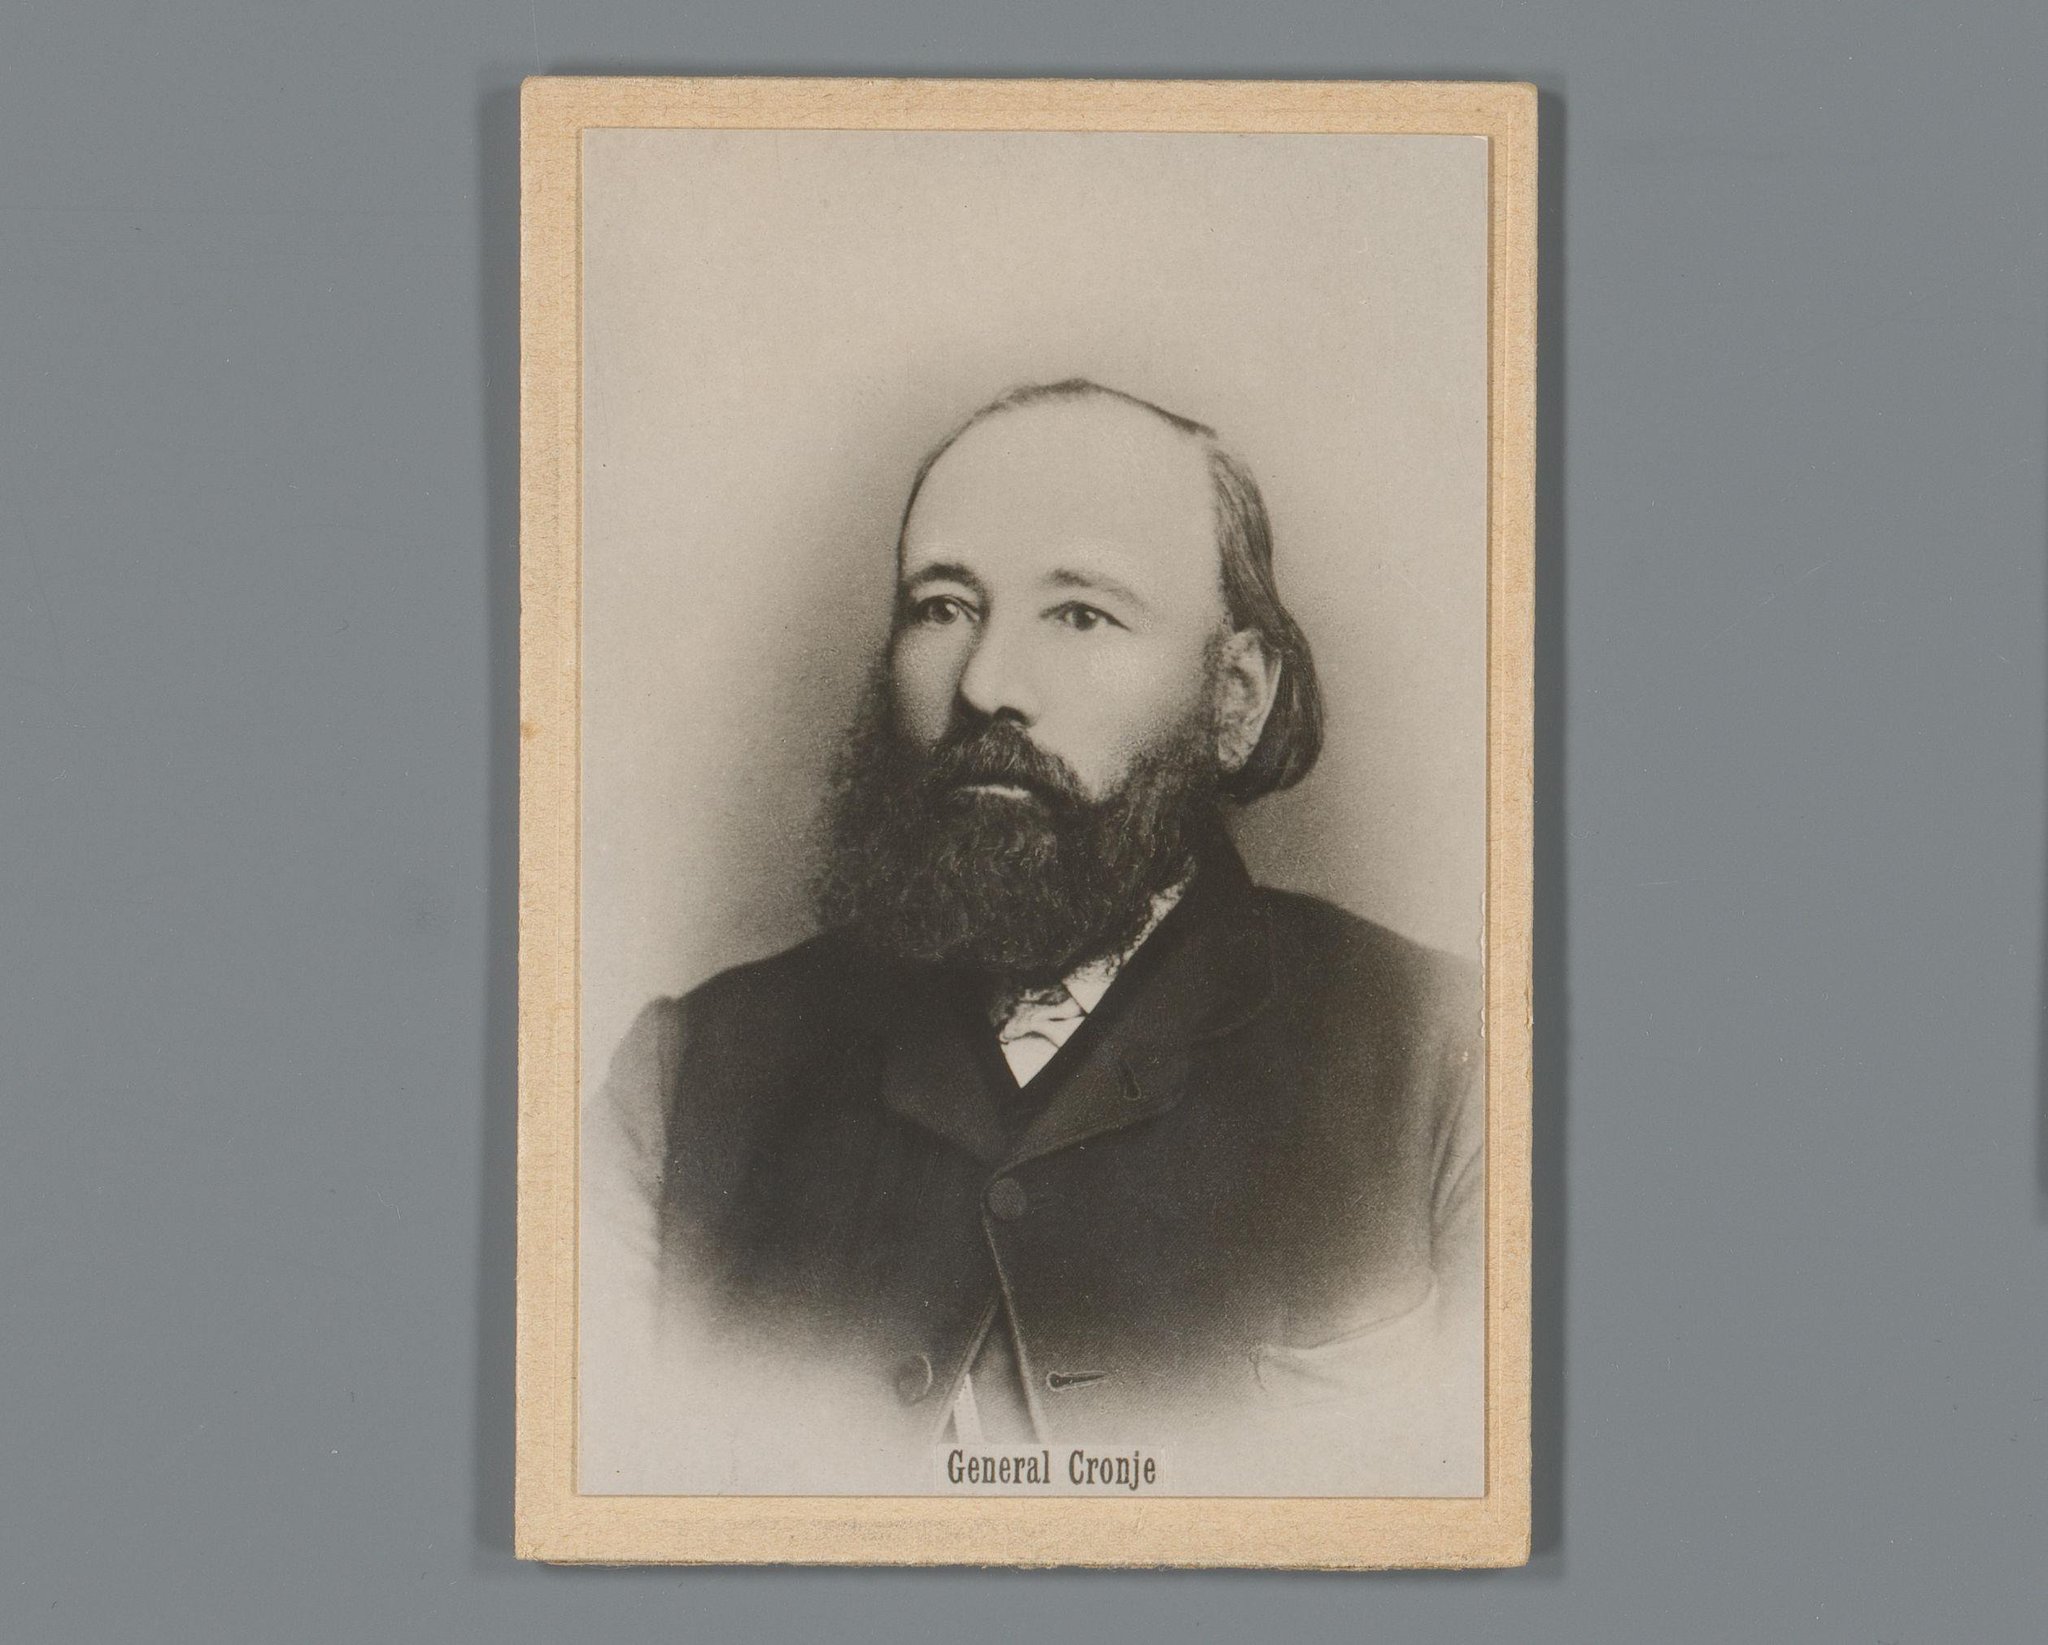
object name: carte de visite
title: Portret van generaal Cronje met reclame voor de Noorse A.S. Freia Chocolade Fabrik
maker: Anonymous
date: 1889-1920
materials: cardboard, photographic support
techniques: gelatin silver print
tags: advertising, chocolate (solid), historical persons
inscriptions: inscription: ‘(...)’